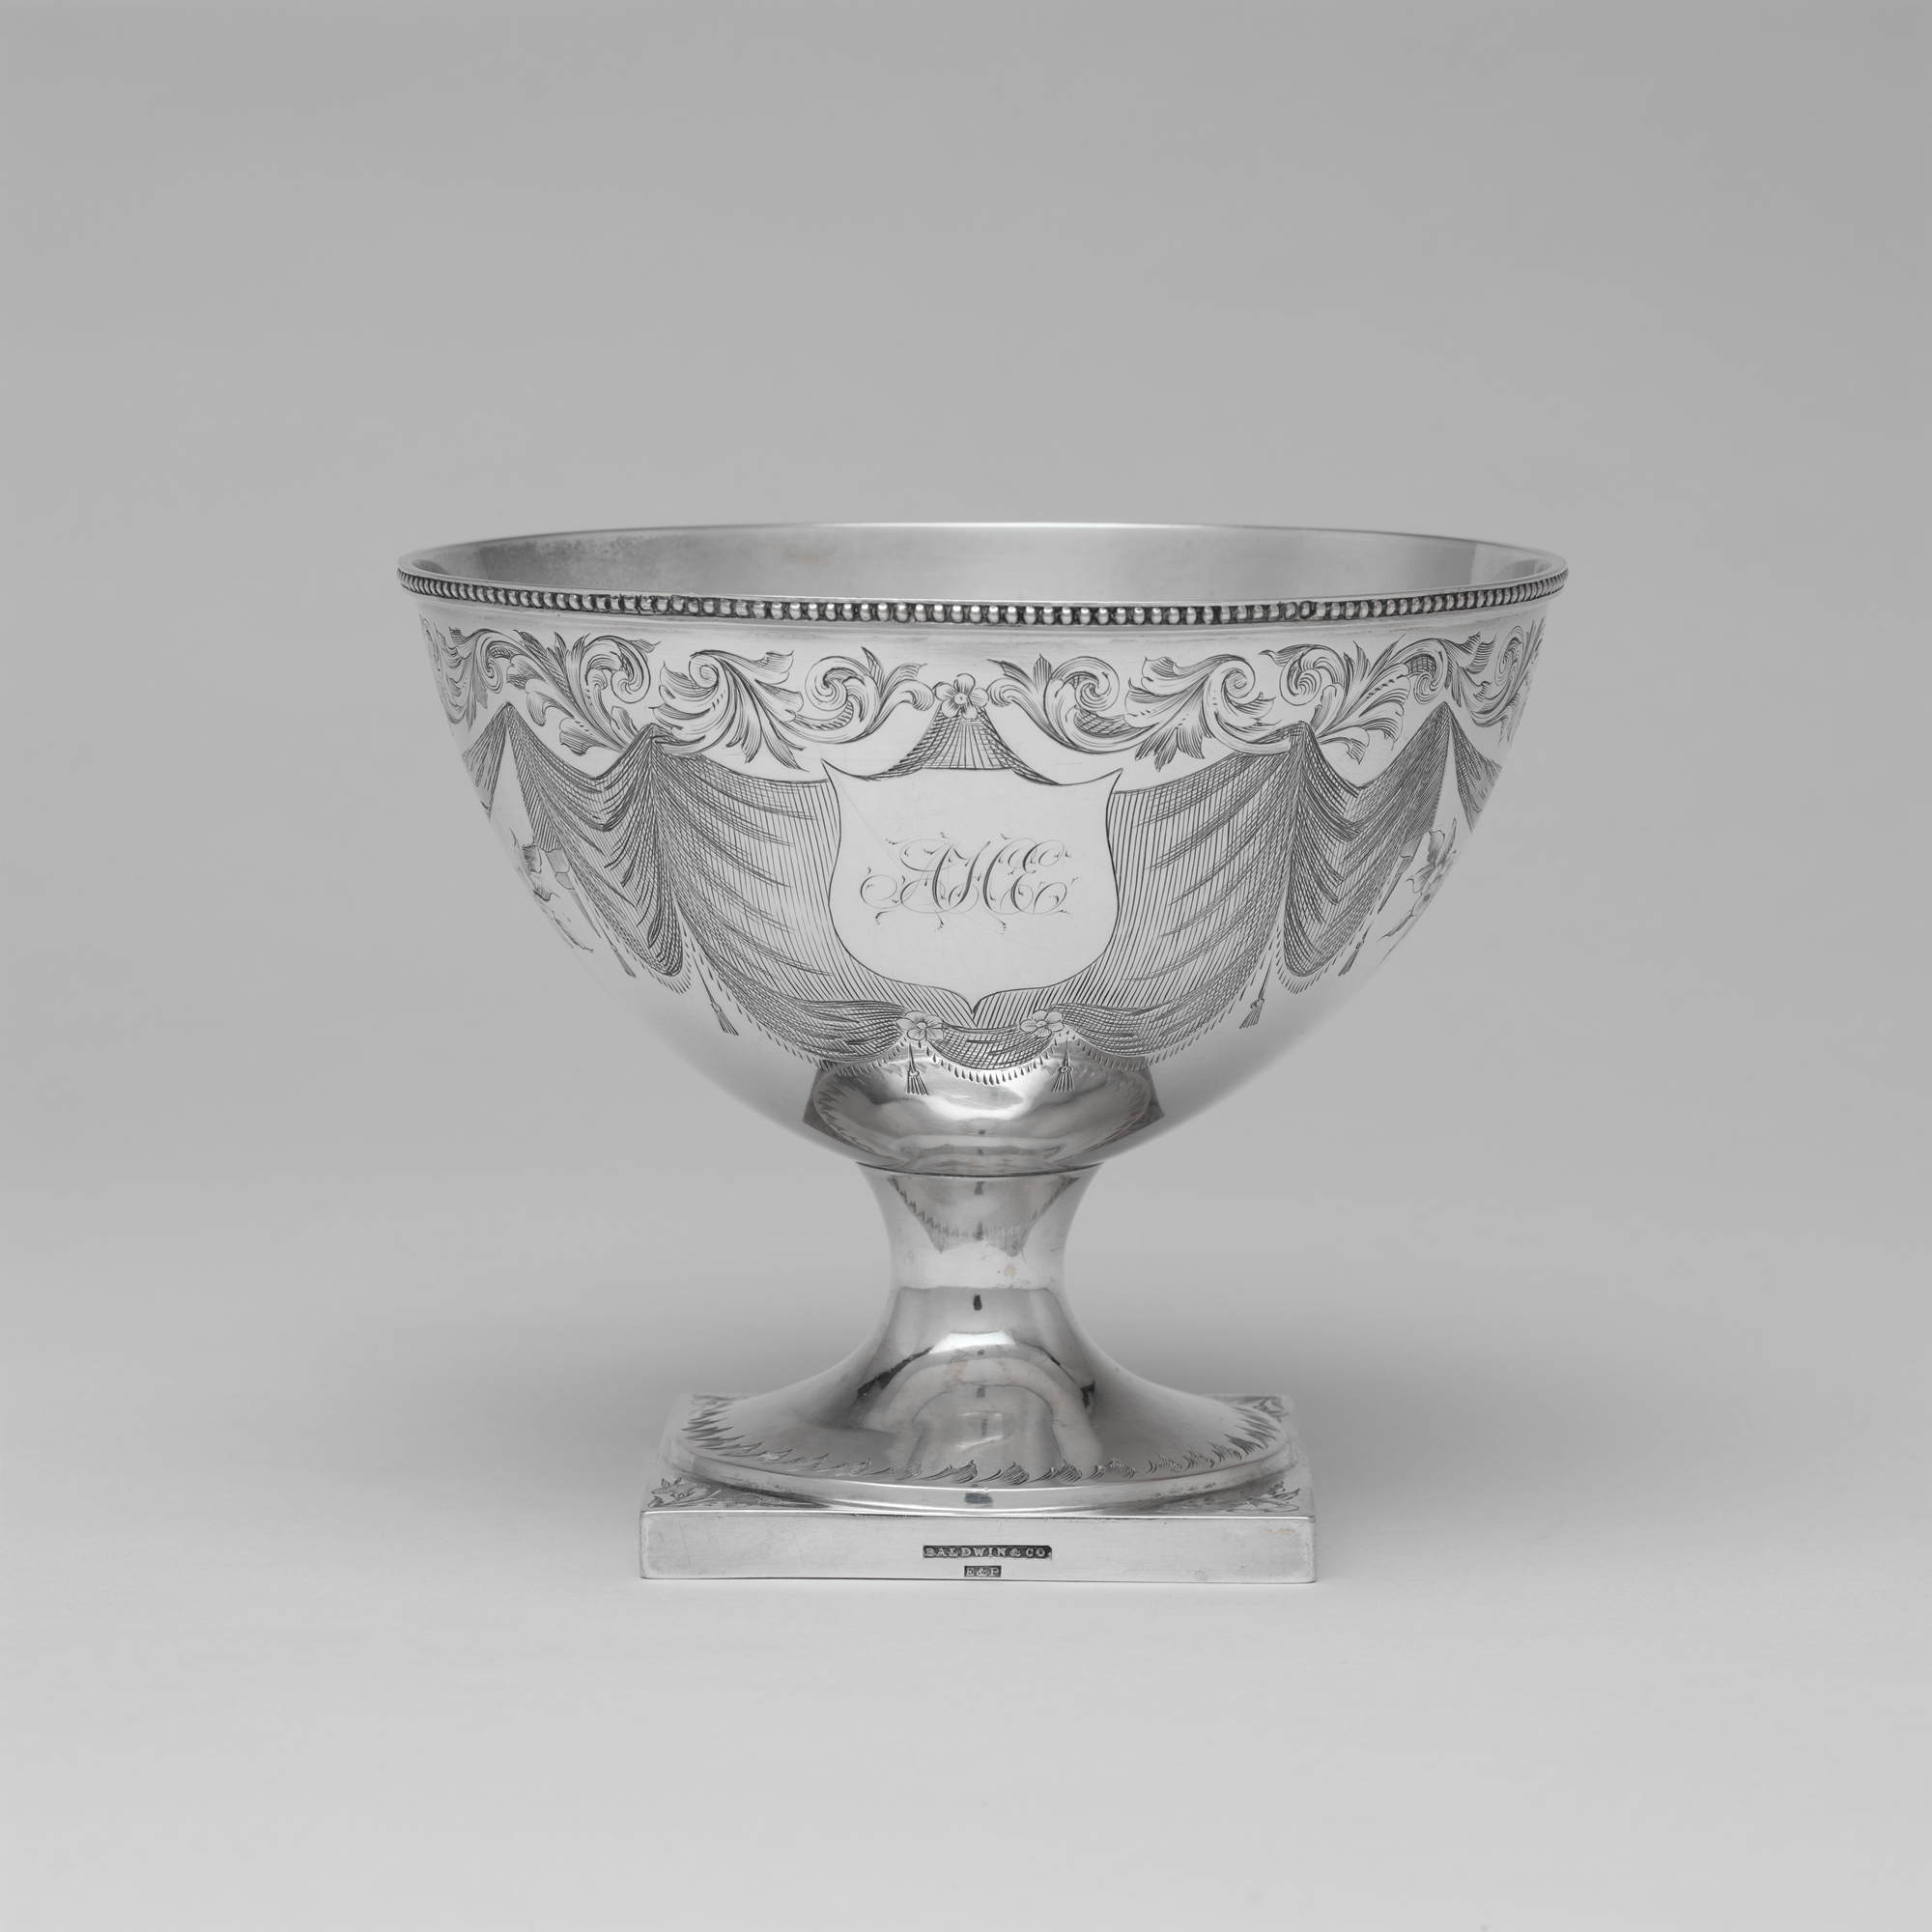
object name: bowl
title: Punch Bowl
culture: american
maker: eoff and phyfe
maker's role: maker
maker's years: 1841-1850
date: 1846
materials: silver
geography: united states